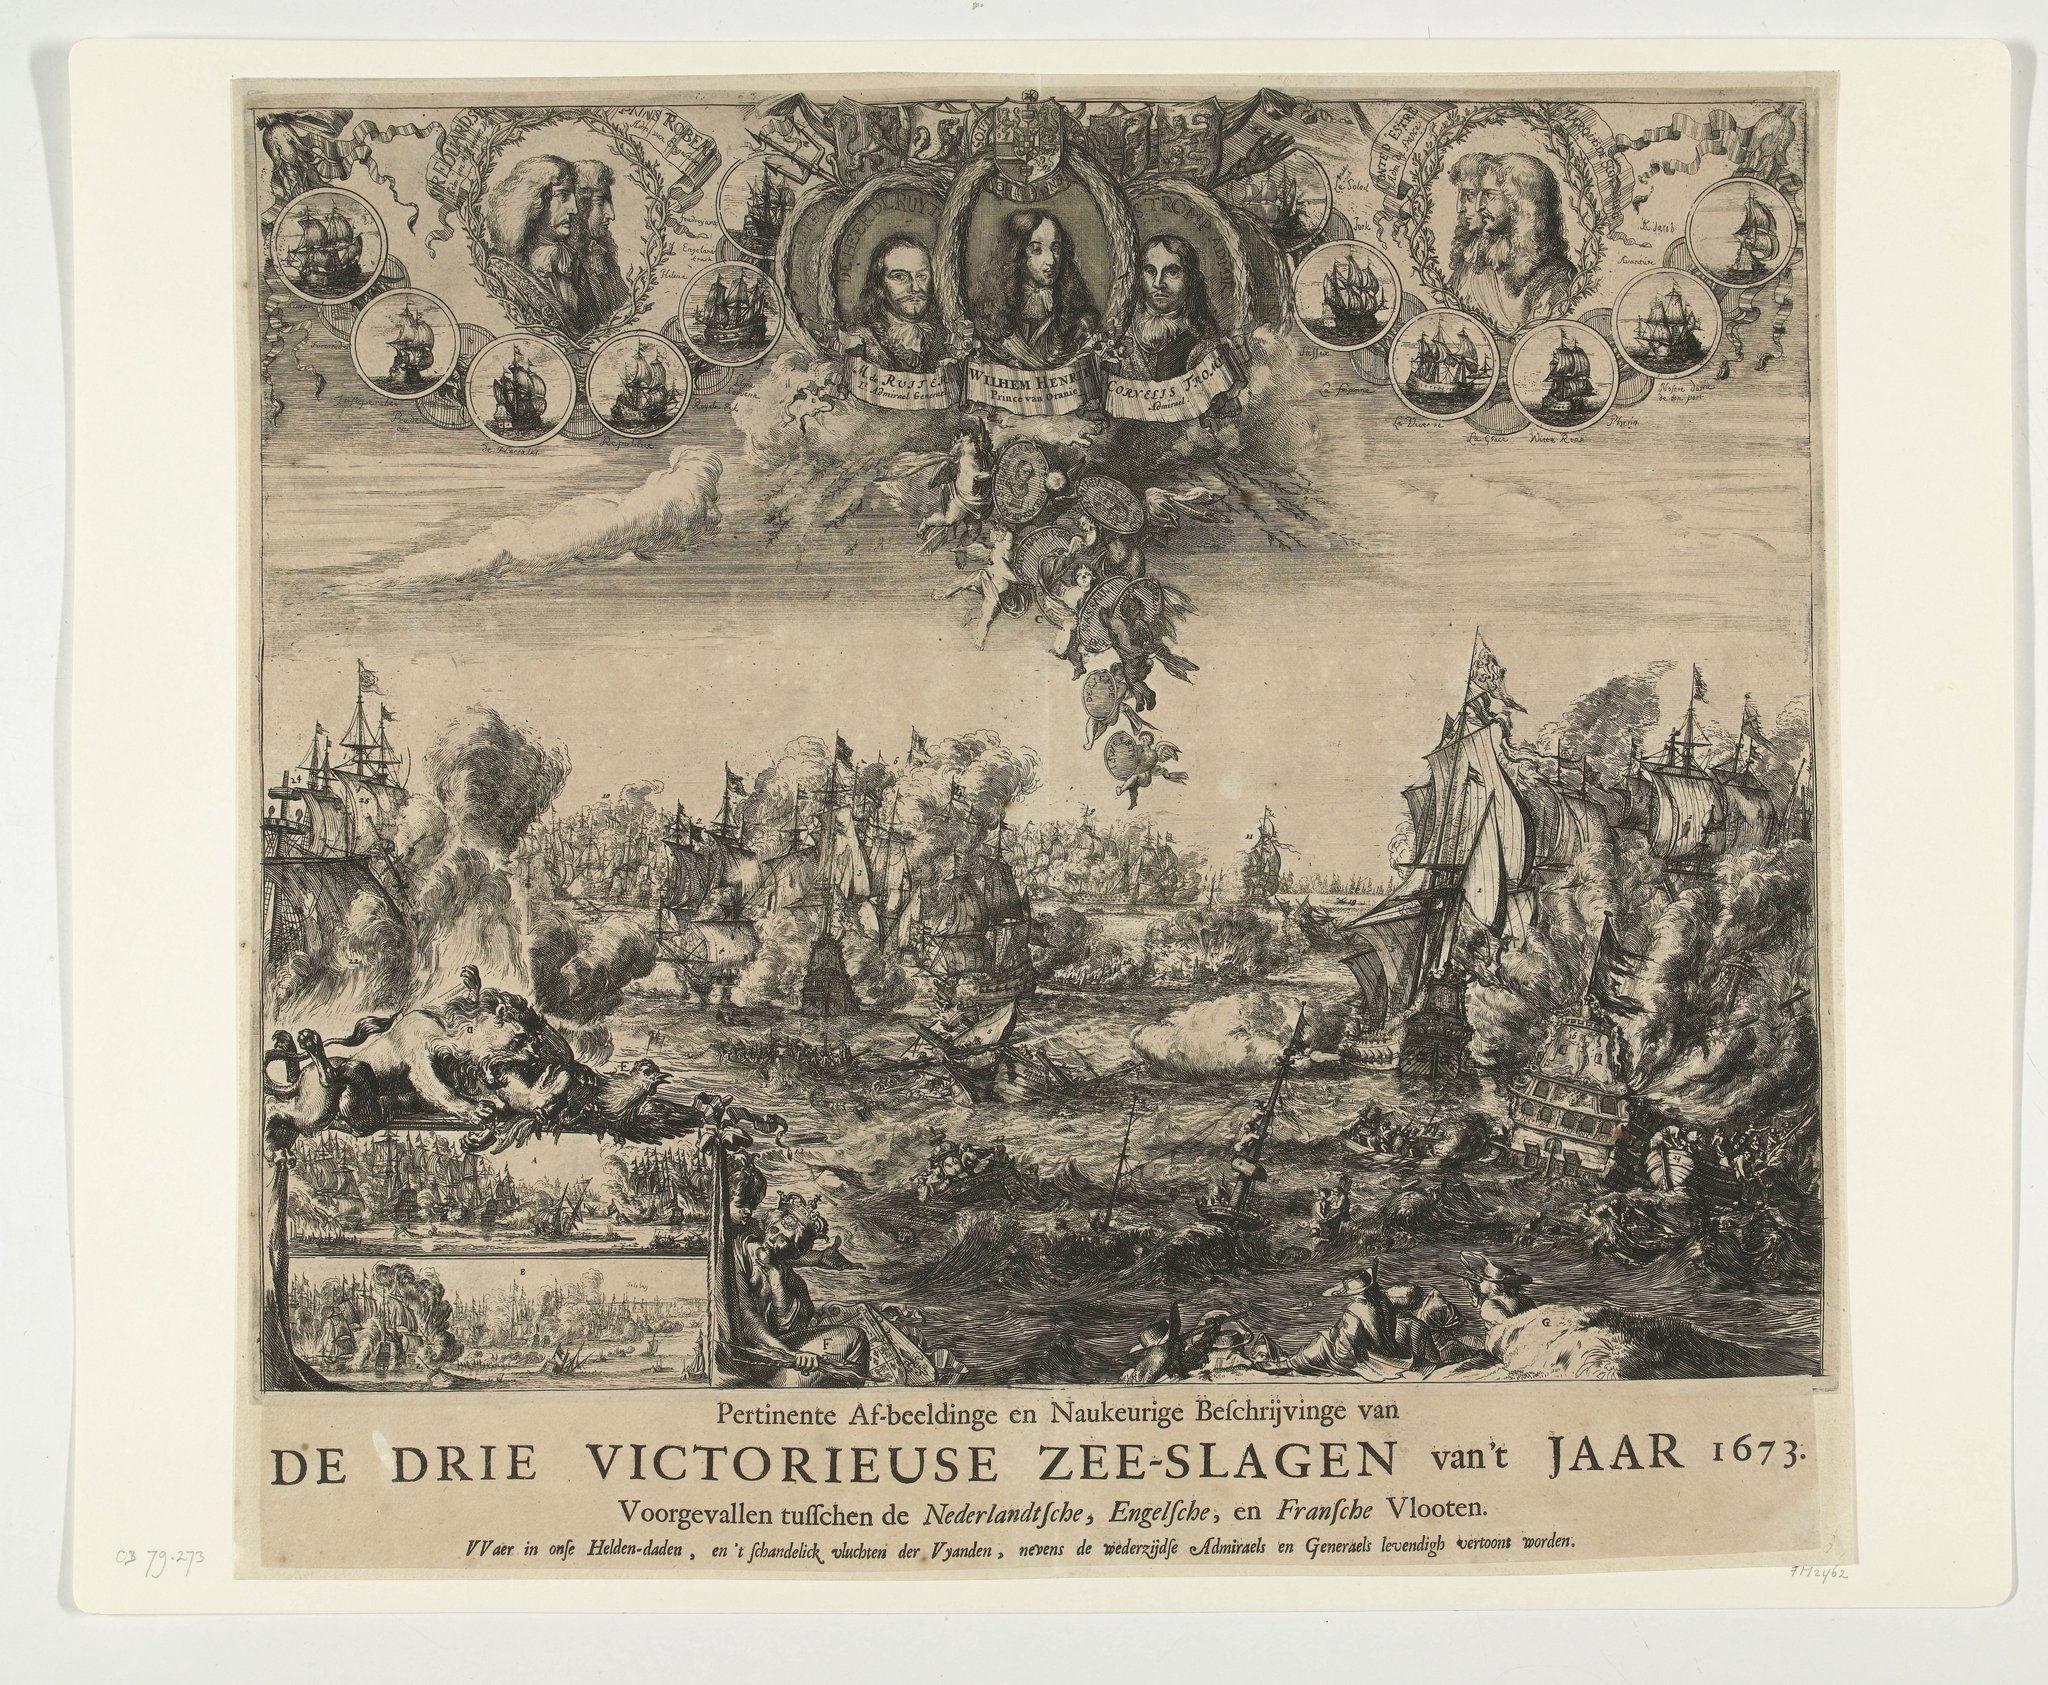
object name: print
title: Pertinente Af-beelding en Naukeurige Beschrijvinge van de Drie Victorieuse Zee-slagen van 't Jaar 1673. Voorgevallen tusschen de Nederlandtsche, Engelsche, en Fransche Vlooten.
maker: romeyn de hooghe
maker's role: draughtsman, goldsmith, painter, print maker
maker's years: 1645-1708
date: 1673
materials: paper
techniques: engraving, etching, letterpress printing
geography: northern netherlands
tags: prague, london, painter, print maker, draughtsman, prinz ruprecht, flushing, michiel adriaenszoon de ruyter, rotterdam, cornelis tromp, william iii (prince of orange and king of england, scotland, and ireland), battle (+ naval force), first battle of schooneveld, second battle of schooneveld, battle of the texel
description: Drie zeeslagen uit de Derde Engelse Oorlog, 1673. Linksonder in een cartouche in het klein de eerste twee zeeslagen voor de Zeeuwse kust op de vlakte van Schoonevelt op 7 juni en 14 juni. De hoofdvoorstelling toont de slag bij Kijkduin op 21 augustus tussen de vloot van de Republiek onder Michiel Adriaenszoon de Ruyter en de gecombineerde Engels-Franse vloot onder Prins Rupert en graaf Jean d'Estrées. Bovenaan medaillons met portretten van Willem III, Michiel Adriaenszoon de Ruyter en Cornelis Tromp. Linksboven portretten van de twee Engelse bevelhebbers en hun belangrijkste schepen, rechts de Fransen met hun schepen. Onder de prent is een tekstblad geplakt met de titel.